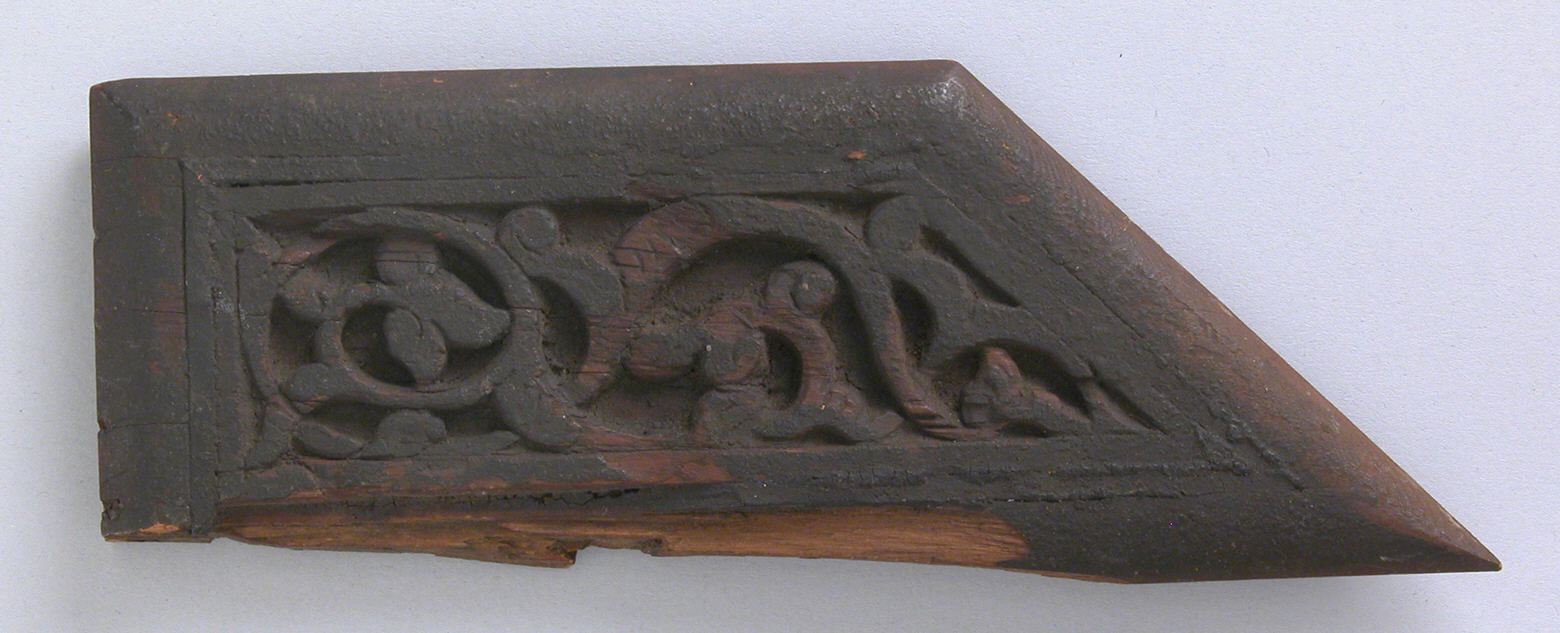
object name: panel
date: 1301-1500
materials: wood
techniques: carving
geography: egypt